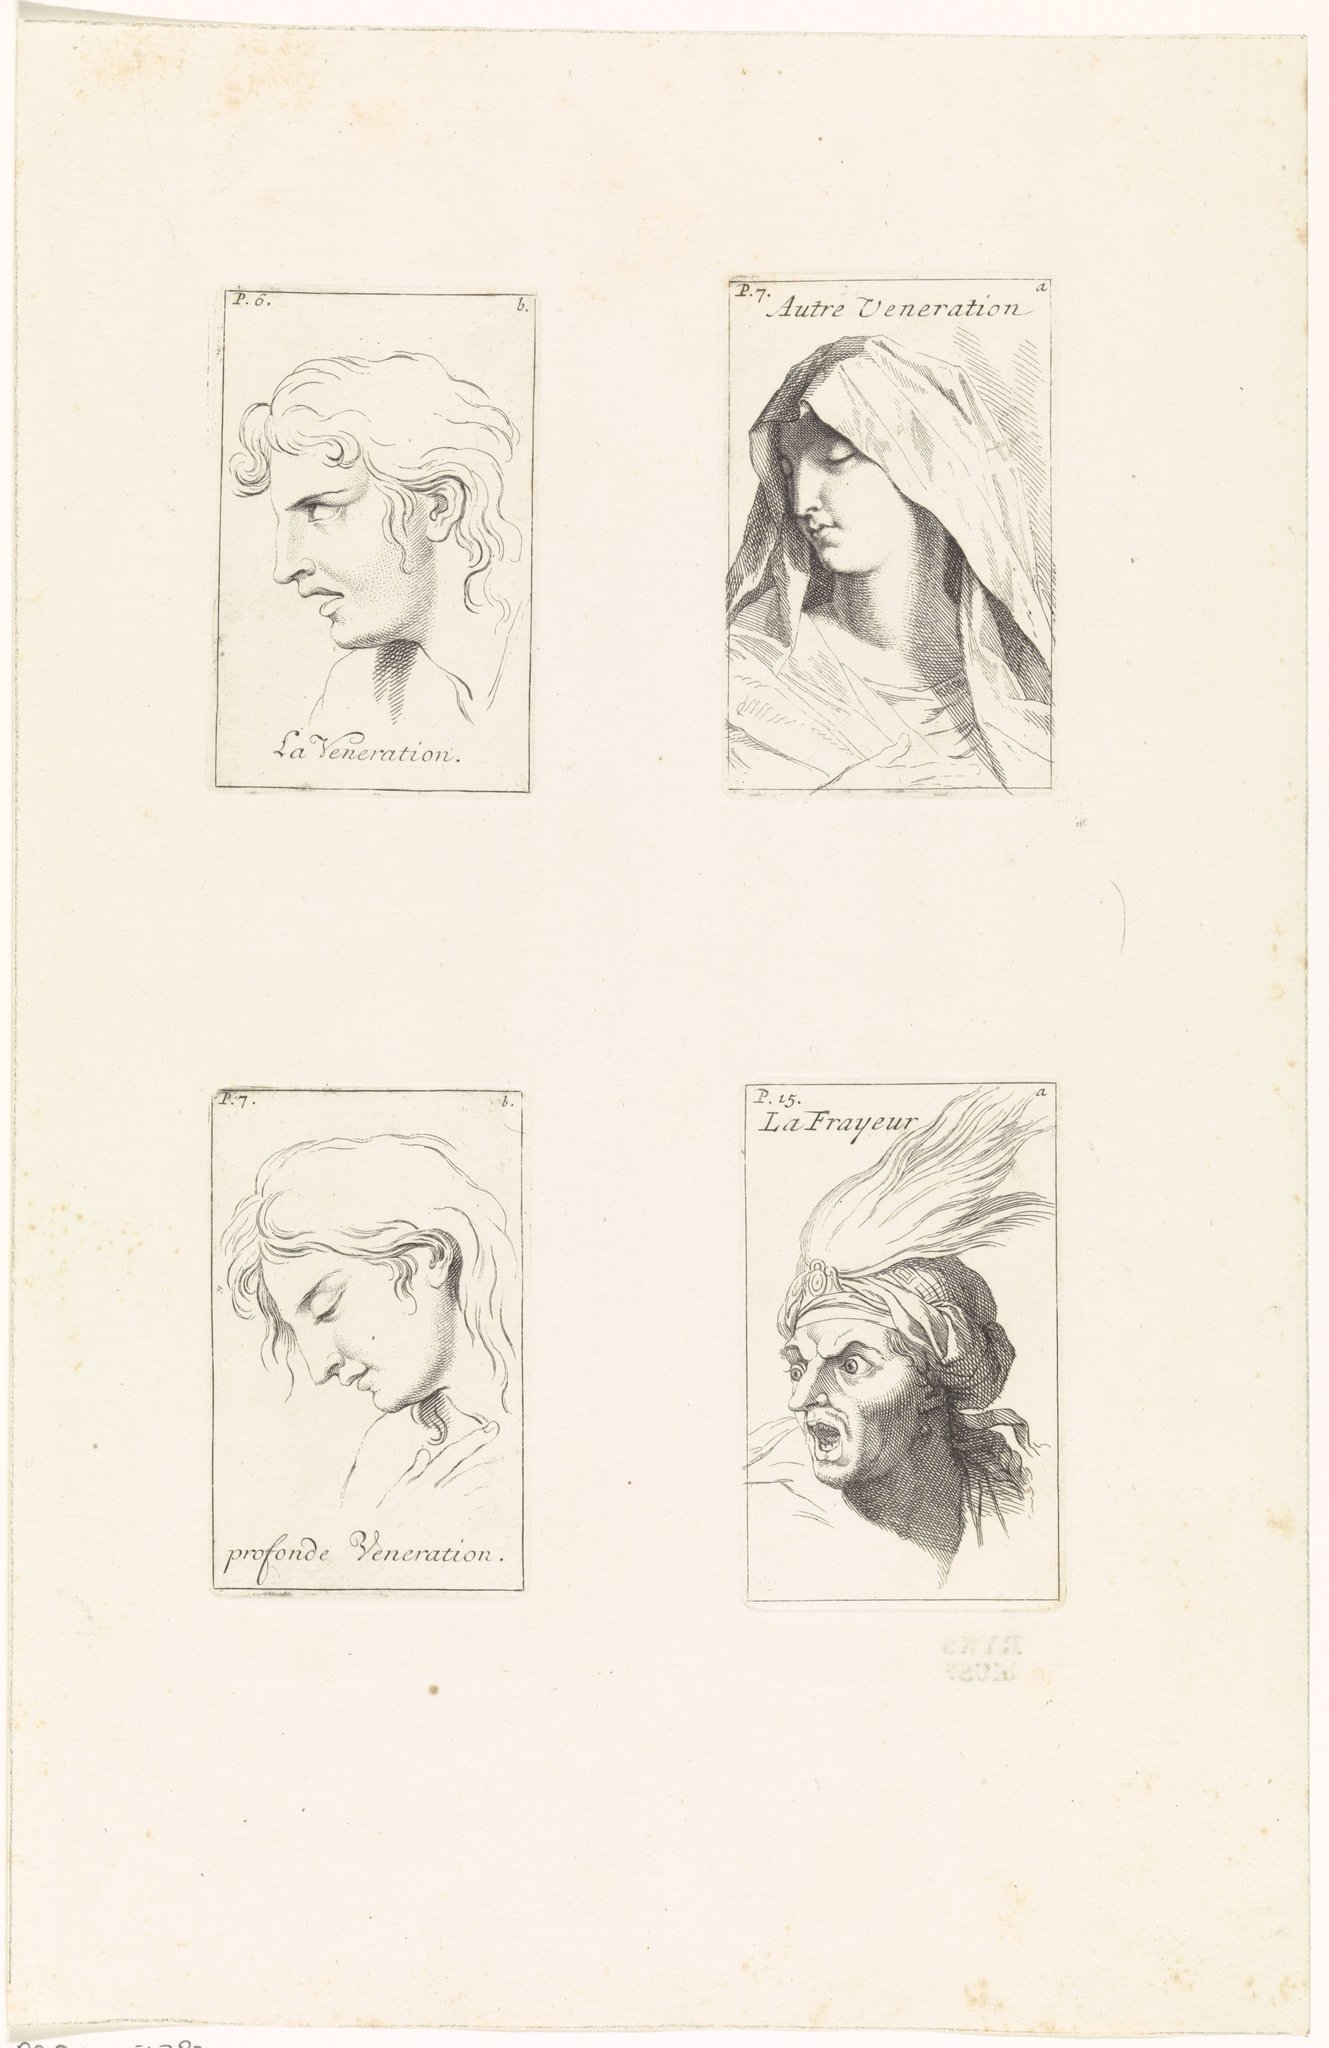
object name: print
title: Voorstellingen van verschillende emoties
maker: bernard picart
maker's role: draughtsman, print maker, publisher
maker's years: 1673-1733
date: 1711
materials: paper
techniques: engraving, etching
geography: amsterdam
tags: morphology of facial expression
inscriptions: collector's mark: Lugt 2165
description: Onversneden blad met vier prenten met voorstellingen van koppen die verschillende emoties uitdrukken. Van links naar rechts, van boven naar beneden: La Veneration, Autre Veneration, profonde Veneration, La Frayeur. De prenten hebben een titel in het Frans en zijn gemerkt met een paginanummer en een letter.